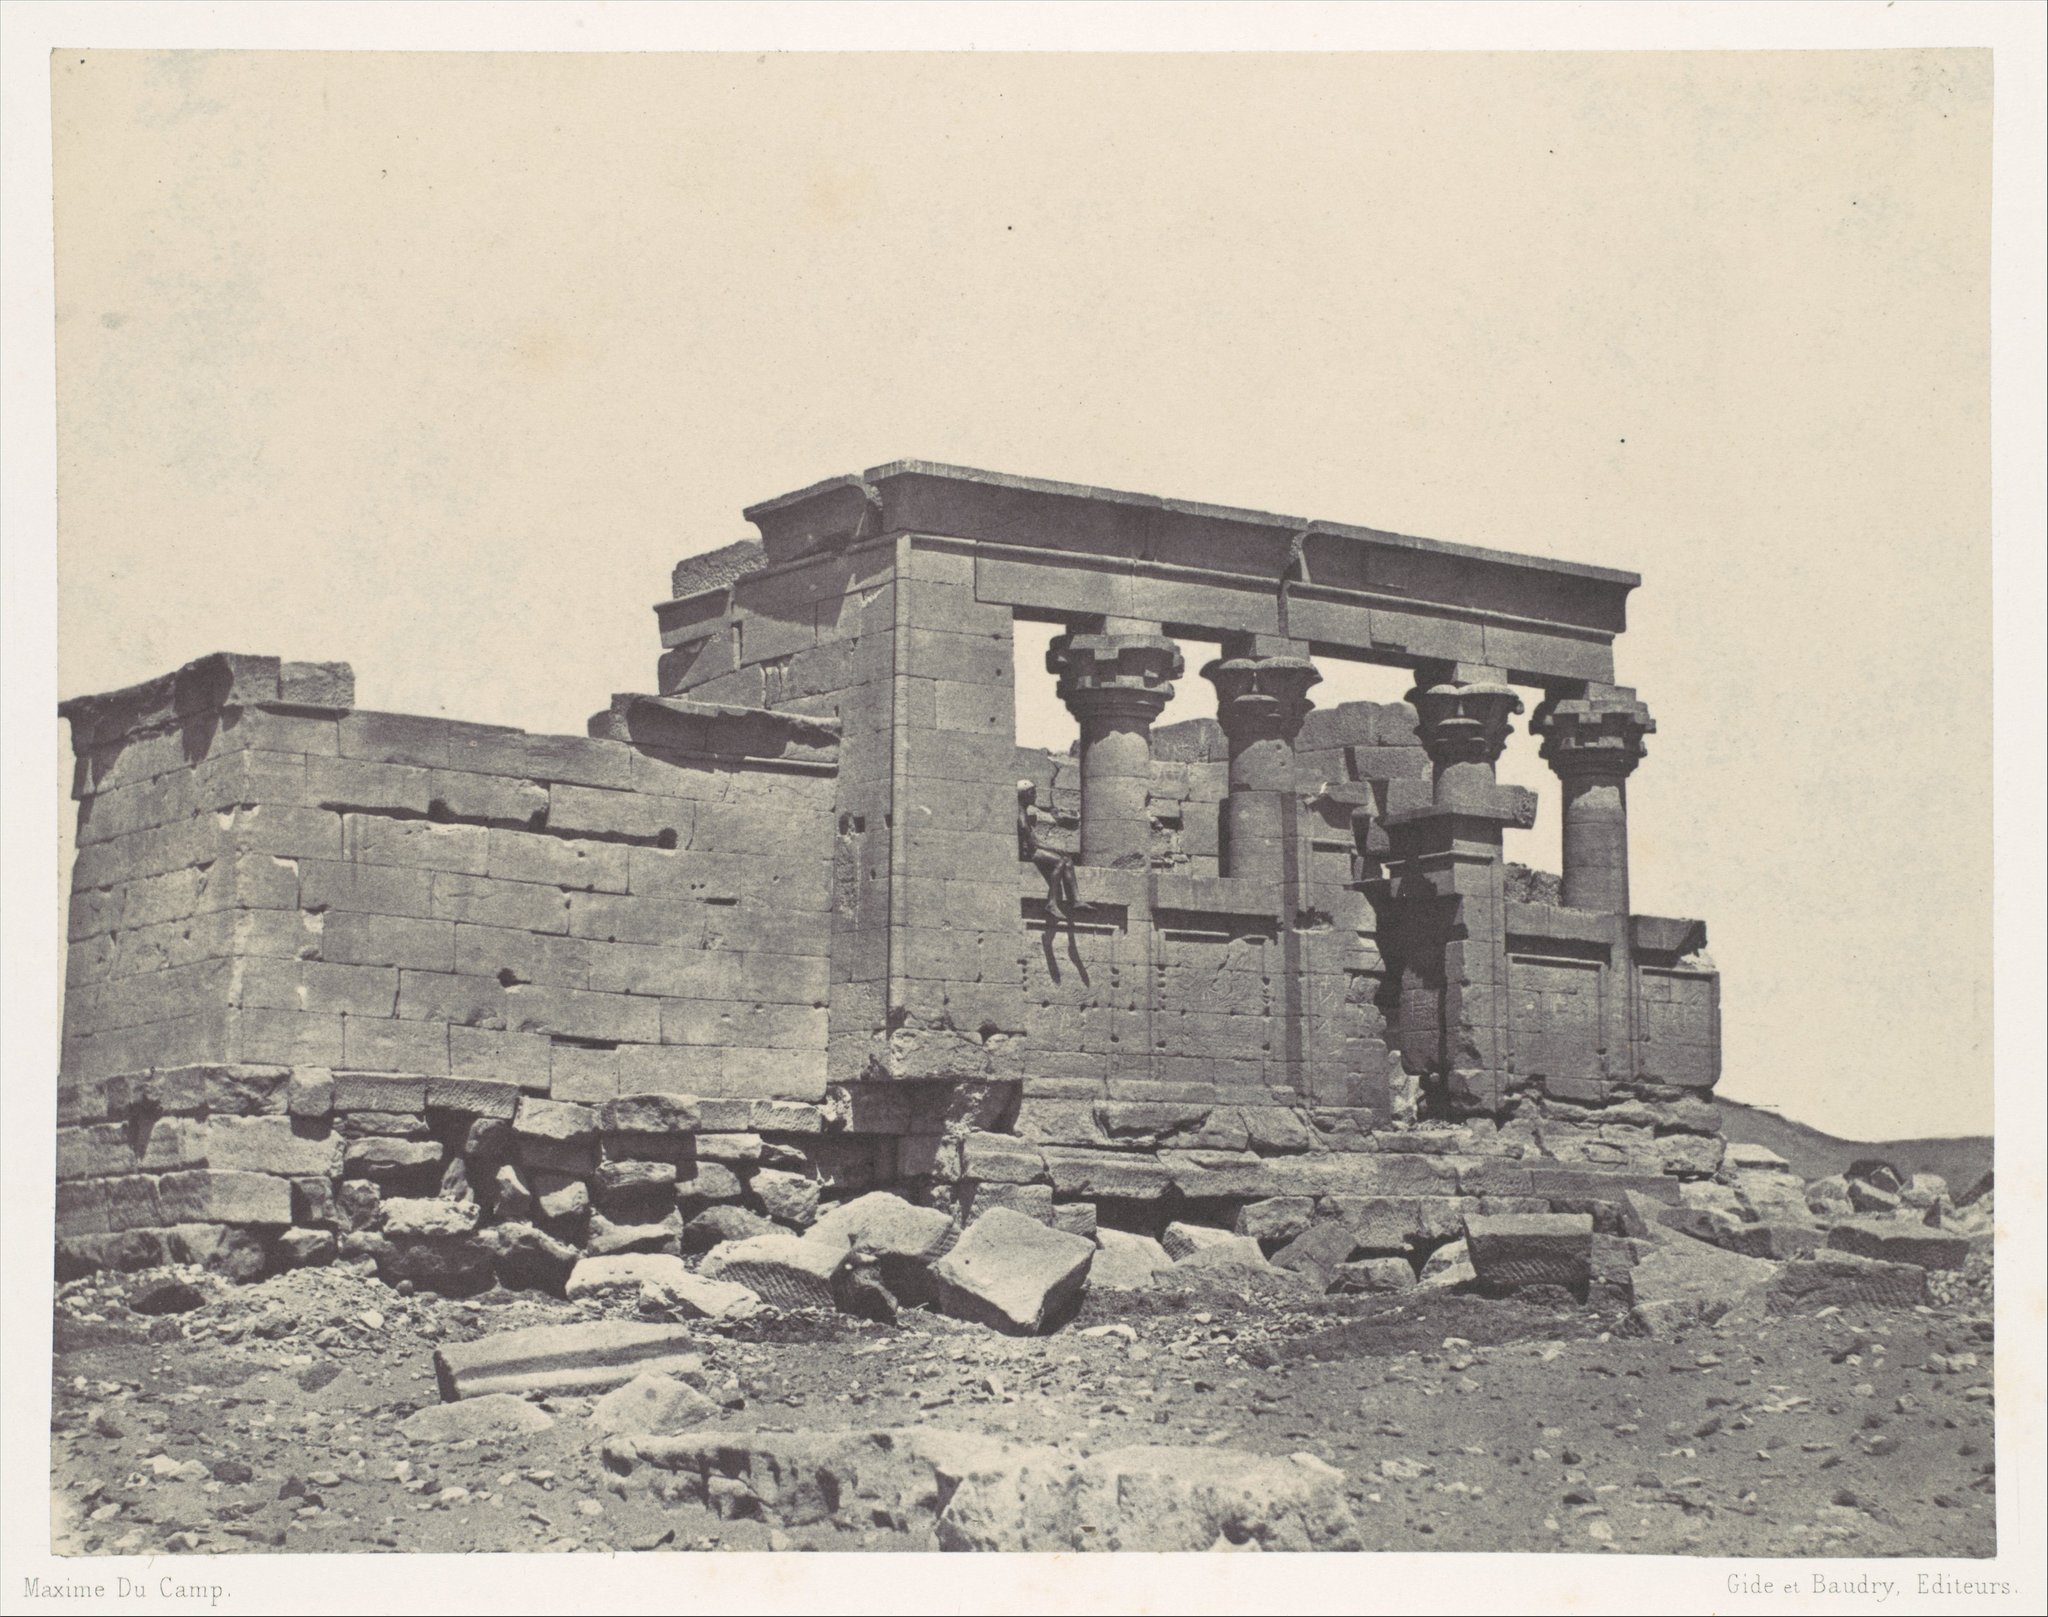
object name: photograph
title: Nubie. Temple de Déböd. Parembole de l'itinéraire d'Antonin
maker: maxime du camp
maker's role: artist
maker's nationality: french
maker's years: 1822-1894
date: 1850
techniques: paper negative, salted paper print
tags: architecture,temples,ruins